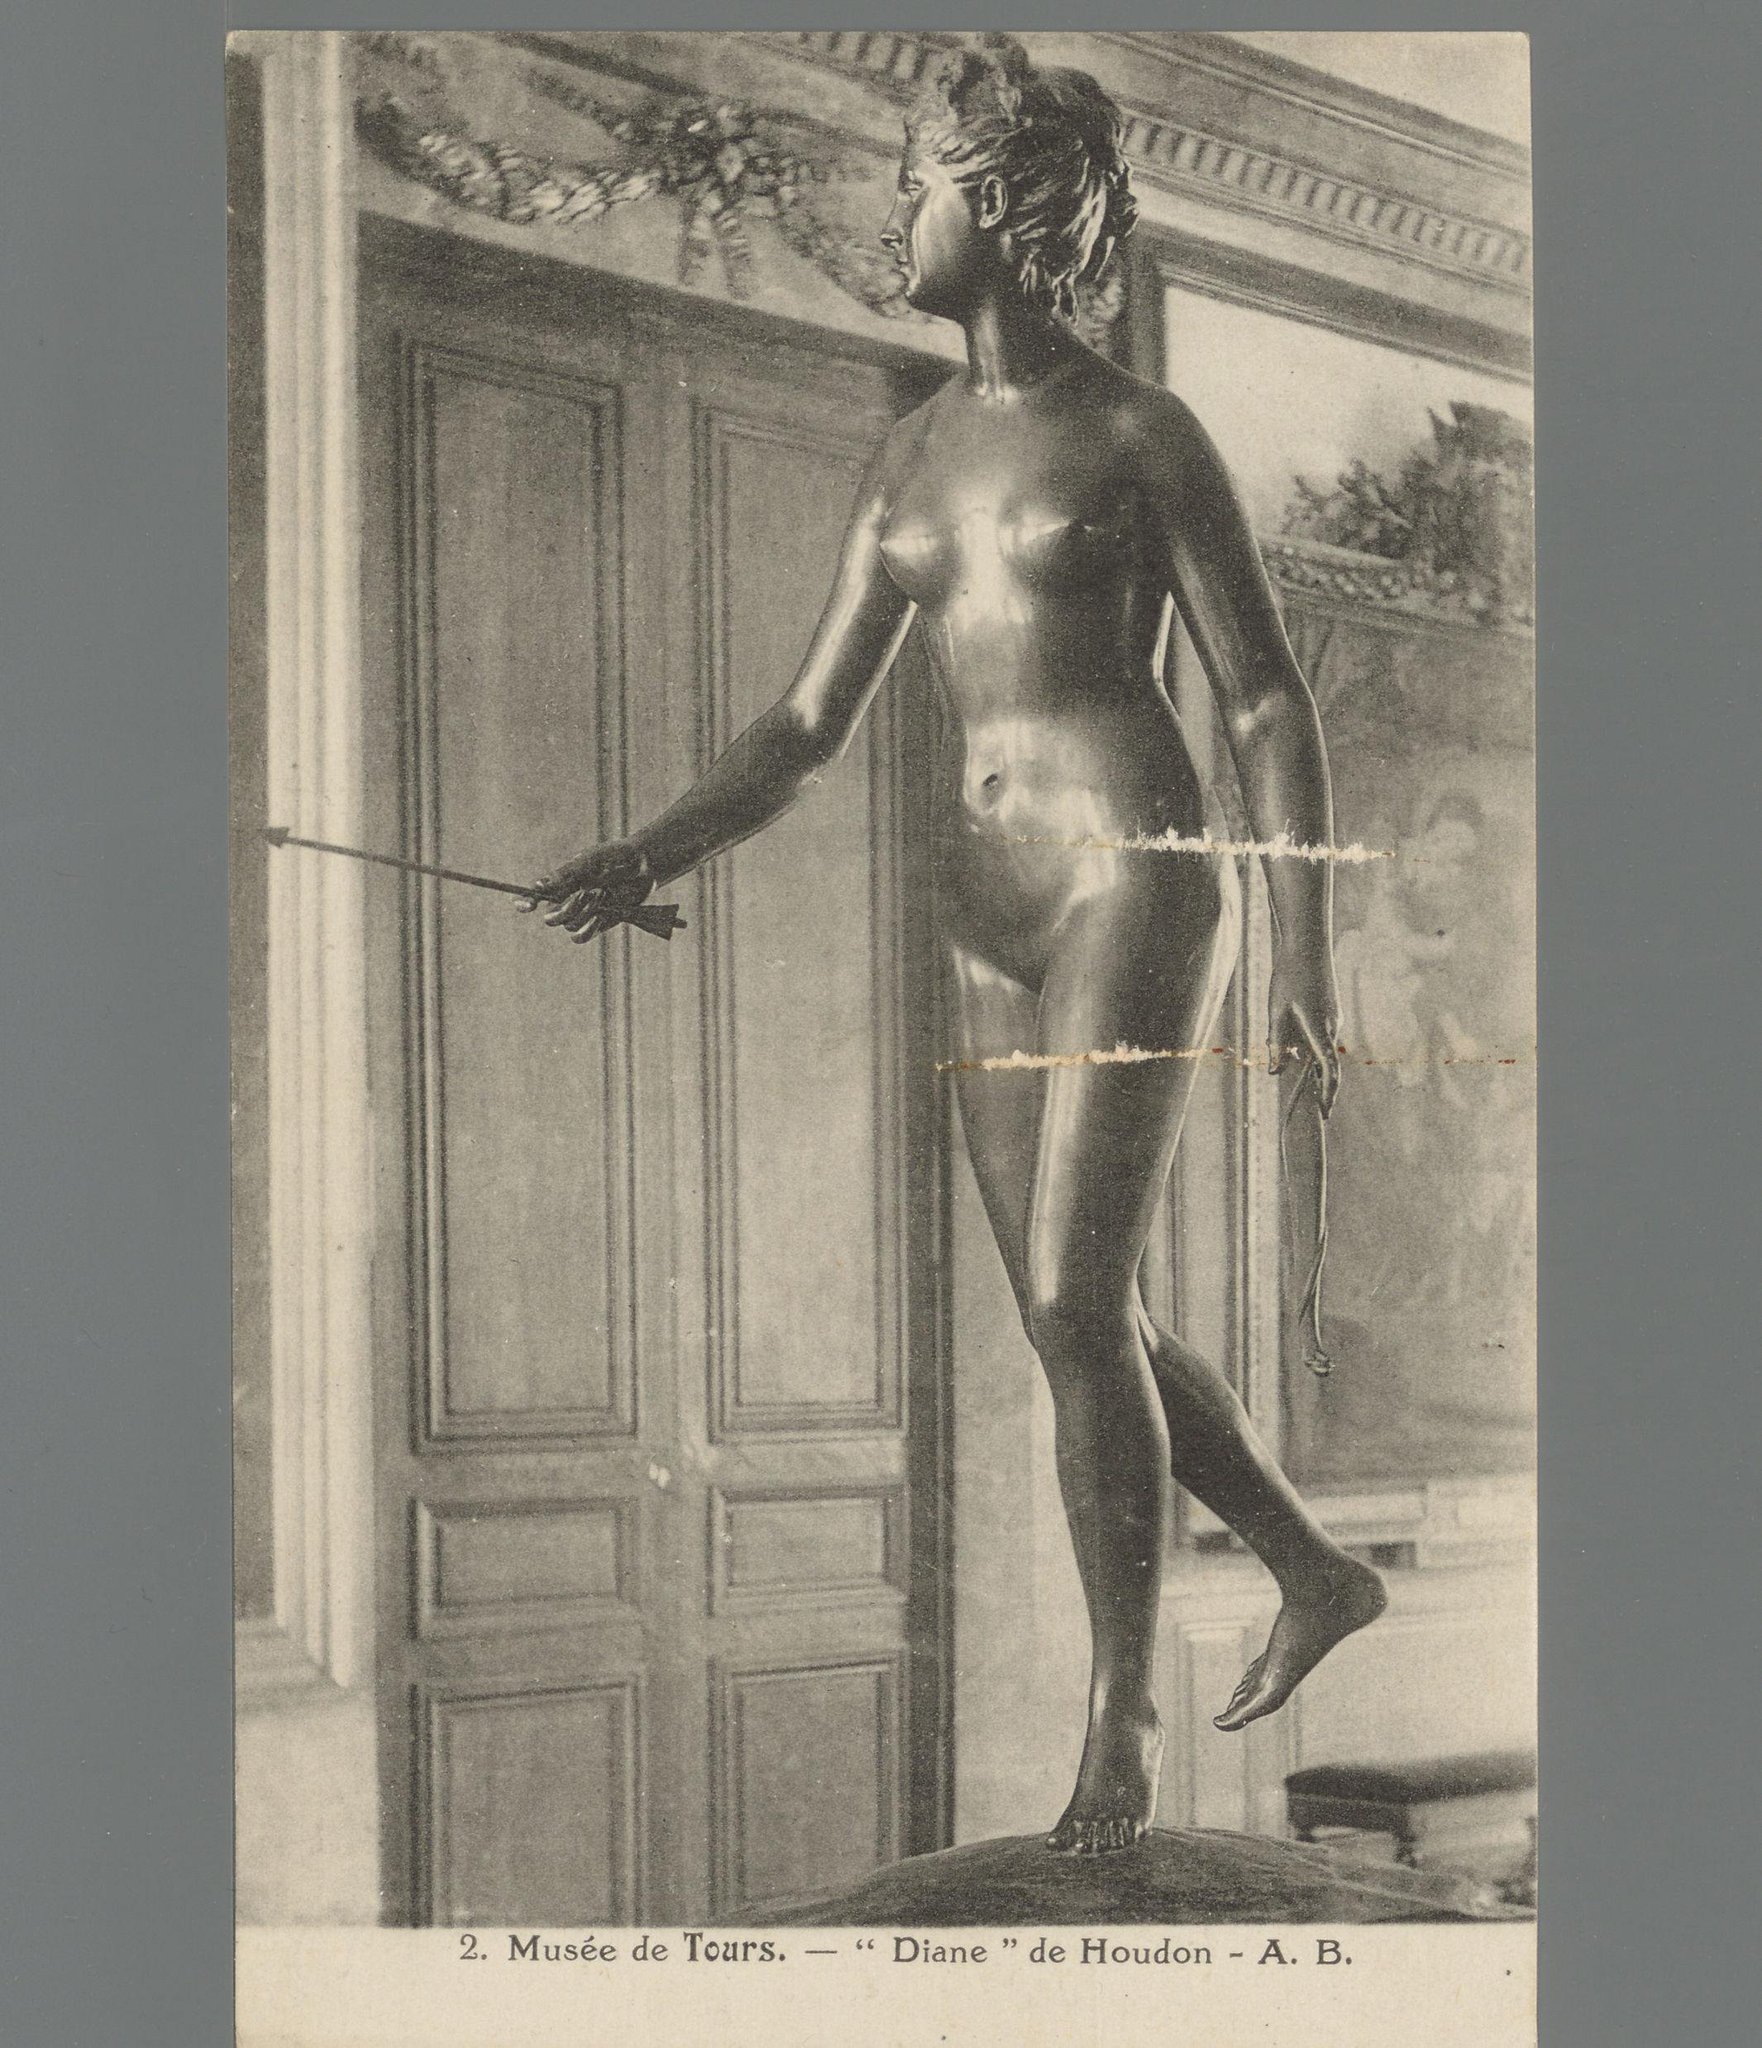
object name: reproduction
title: Musée de Tours.- "Diane" de Houdon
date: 1903-1930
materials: cardboard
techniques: photograph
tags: statues, paintings, etc. ~ objects of worship in roman religion, permanent exhibition, museum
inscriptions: collector's mark: ‘AFE v S’, inscription: ‘A.B.’